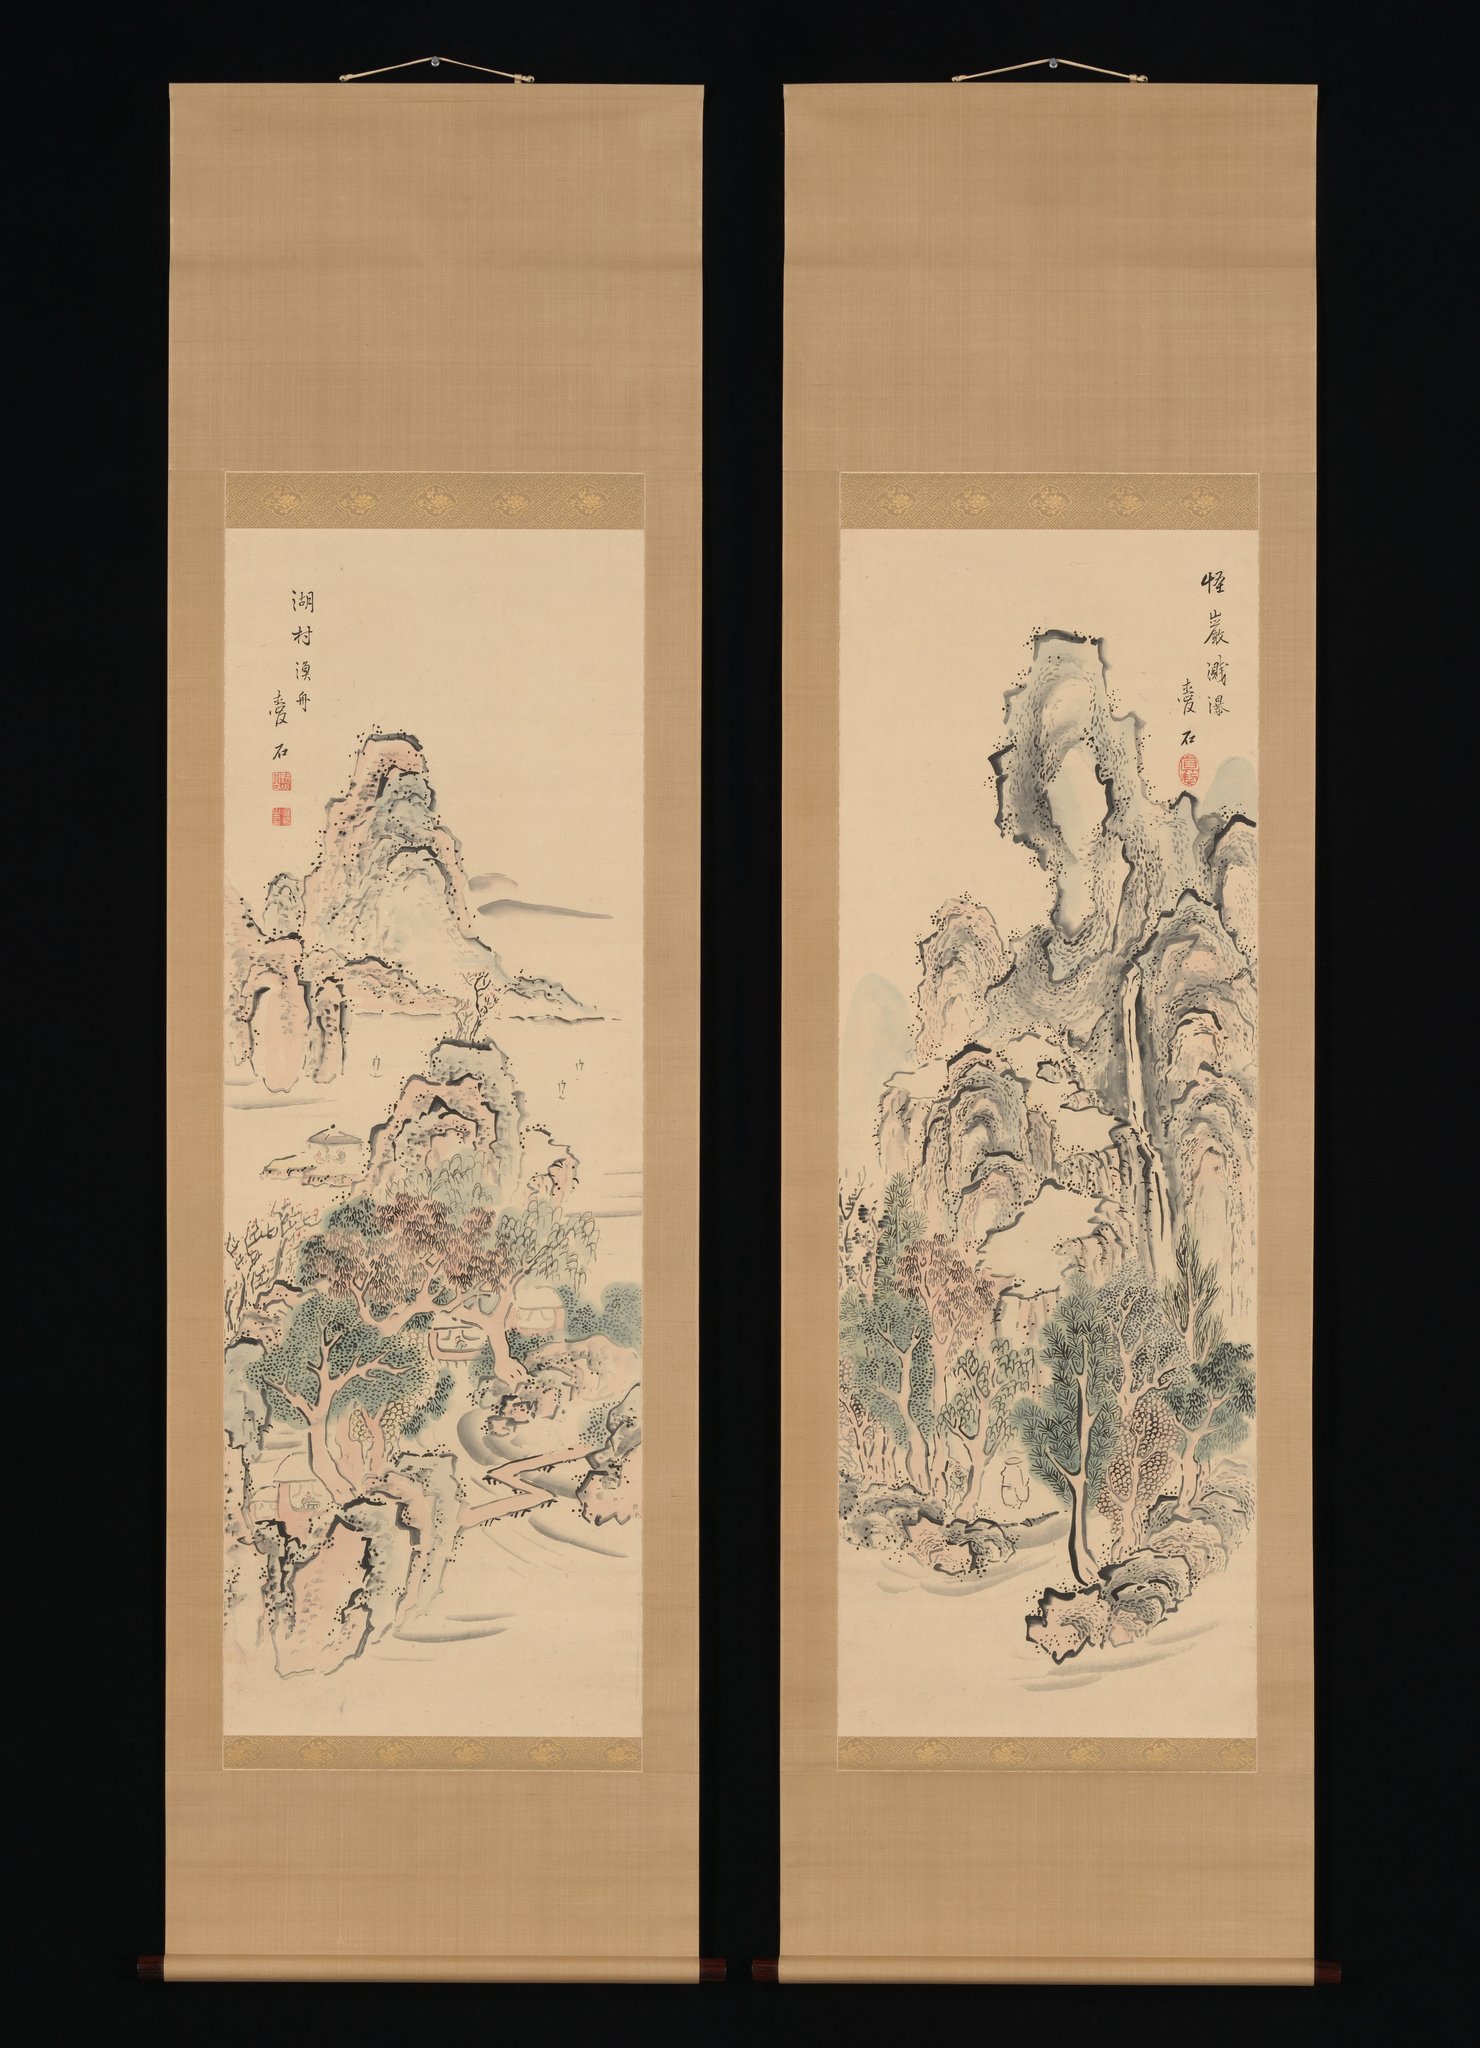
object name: hanging scroll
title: Fantastic Rocks with Cascading Waterfall; Fishing Boats by a Lake Hamlet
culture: japanese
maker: aiseki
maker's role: artist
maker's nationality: japanese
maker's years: 1800-1849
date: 1801-1850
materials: ink, paper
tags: waterfalls,landscapes